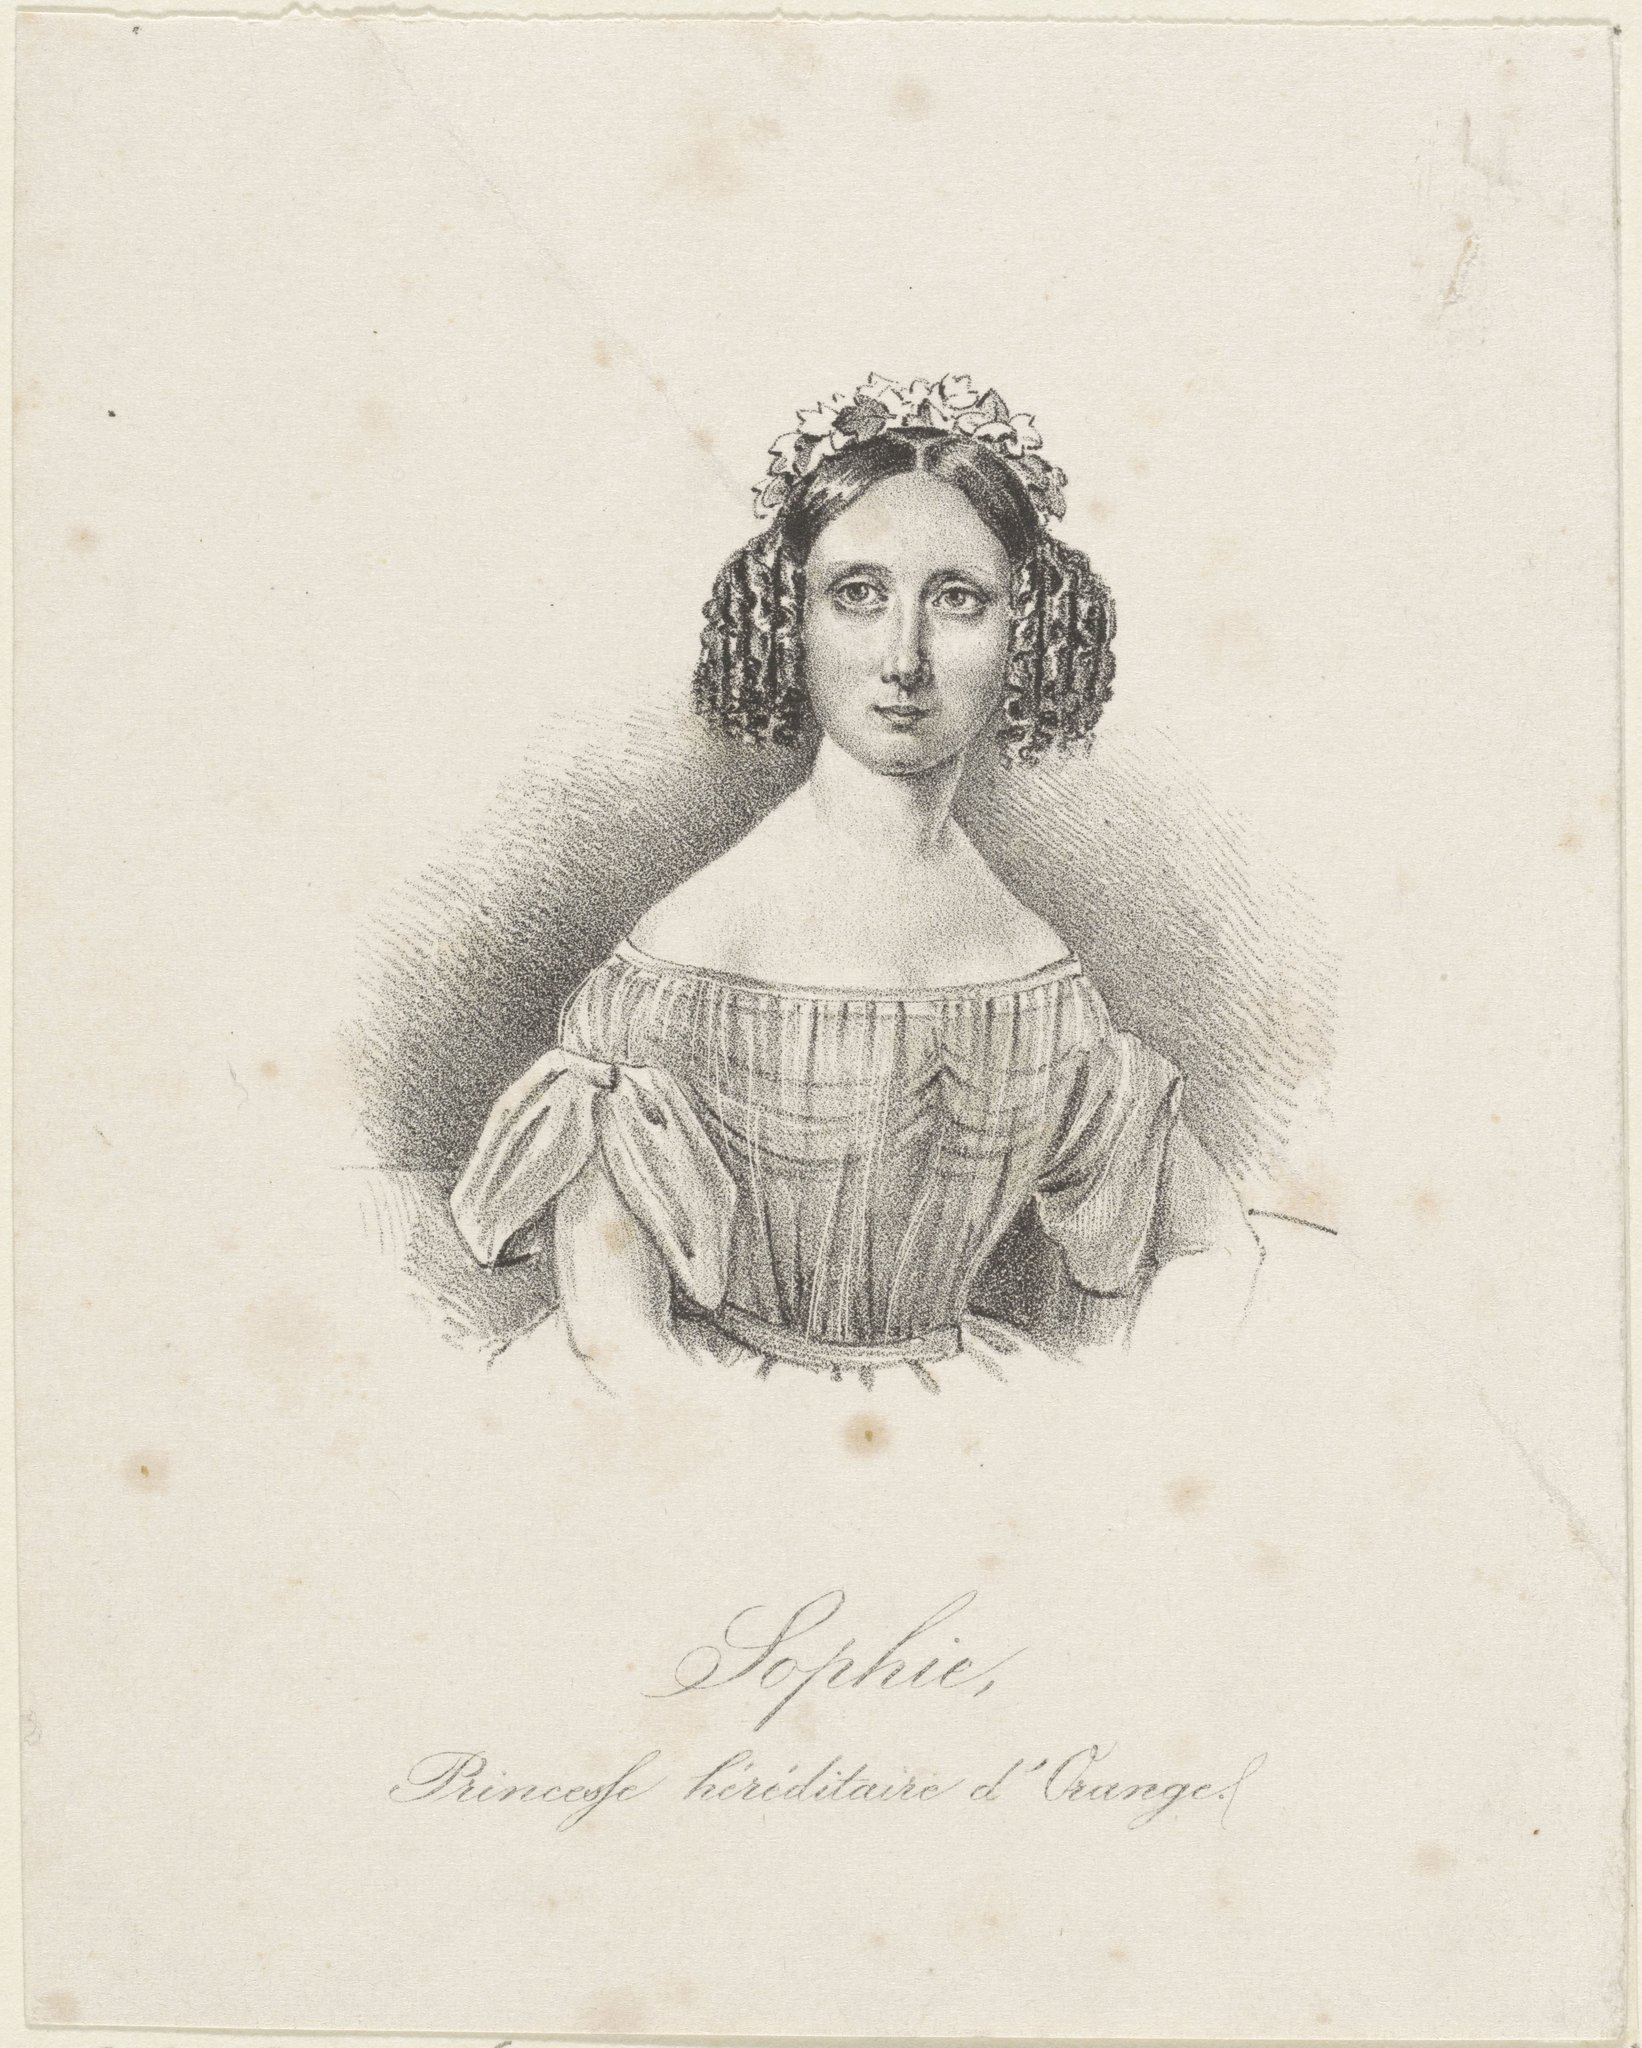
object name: print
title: Portret van Sophie van Württemberg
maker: Anonymous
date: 1839-1899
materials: paper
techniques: lithograph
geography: netherlands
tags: the hague, sophia frederika mathilda van württemberg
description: Portret van Sophie. In de ondermarge haar naam en titel in het Frans.